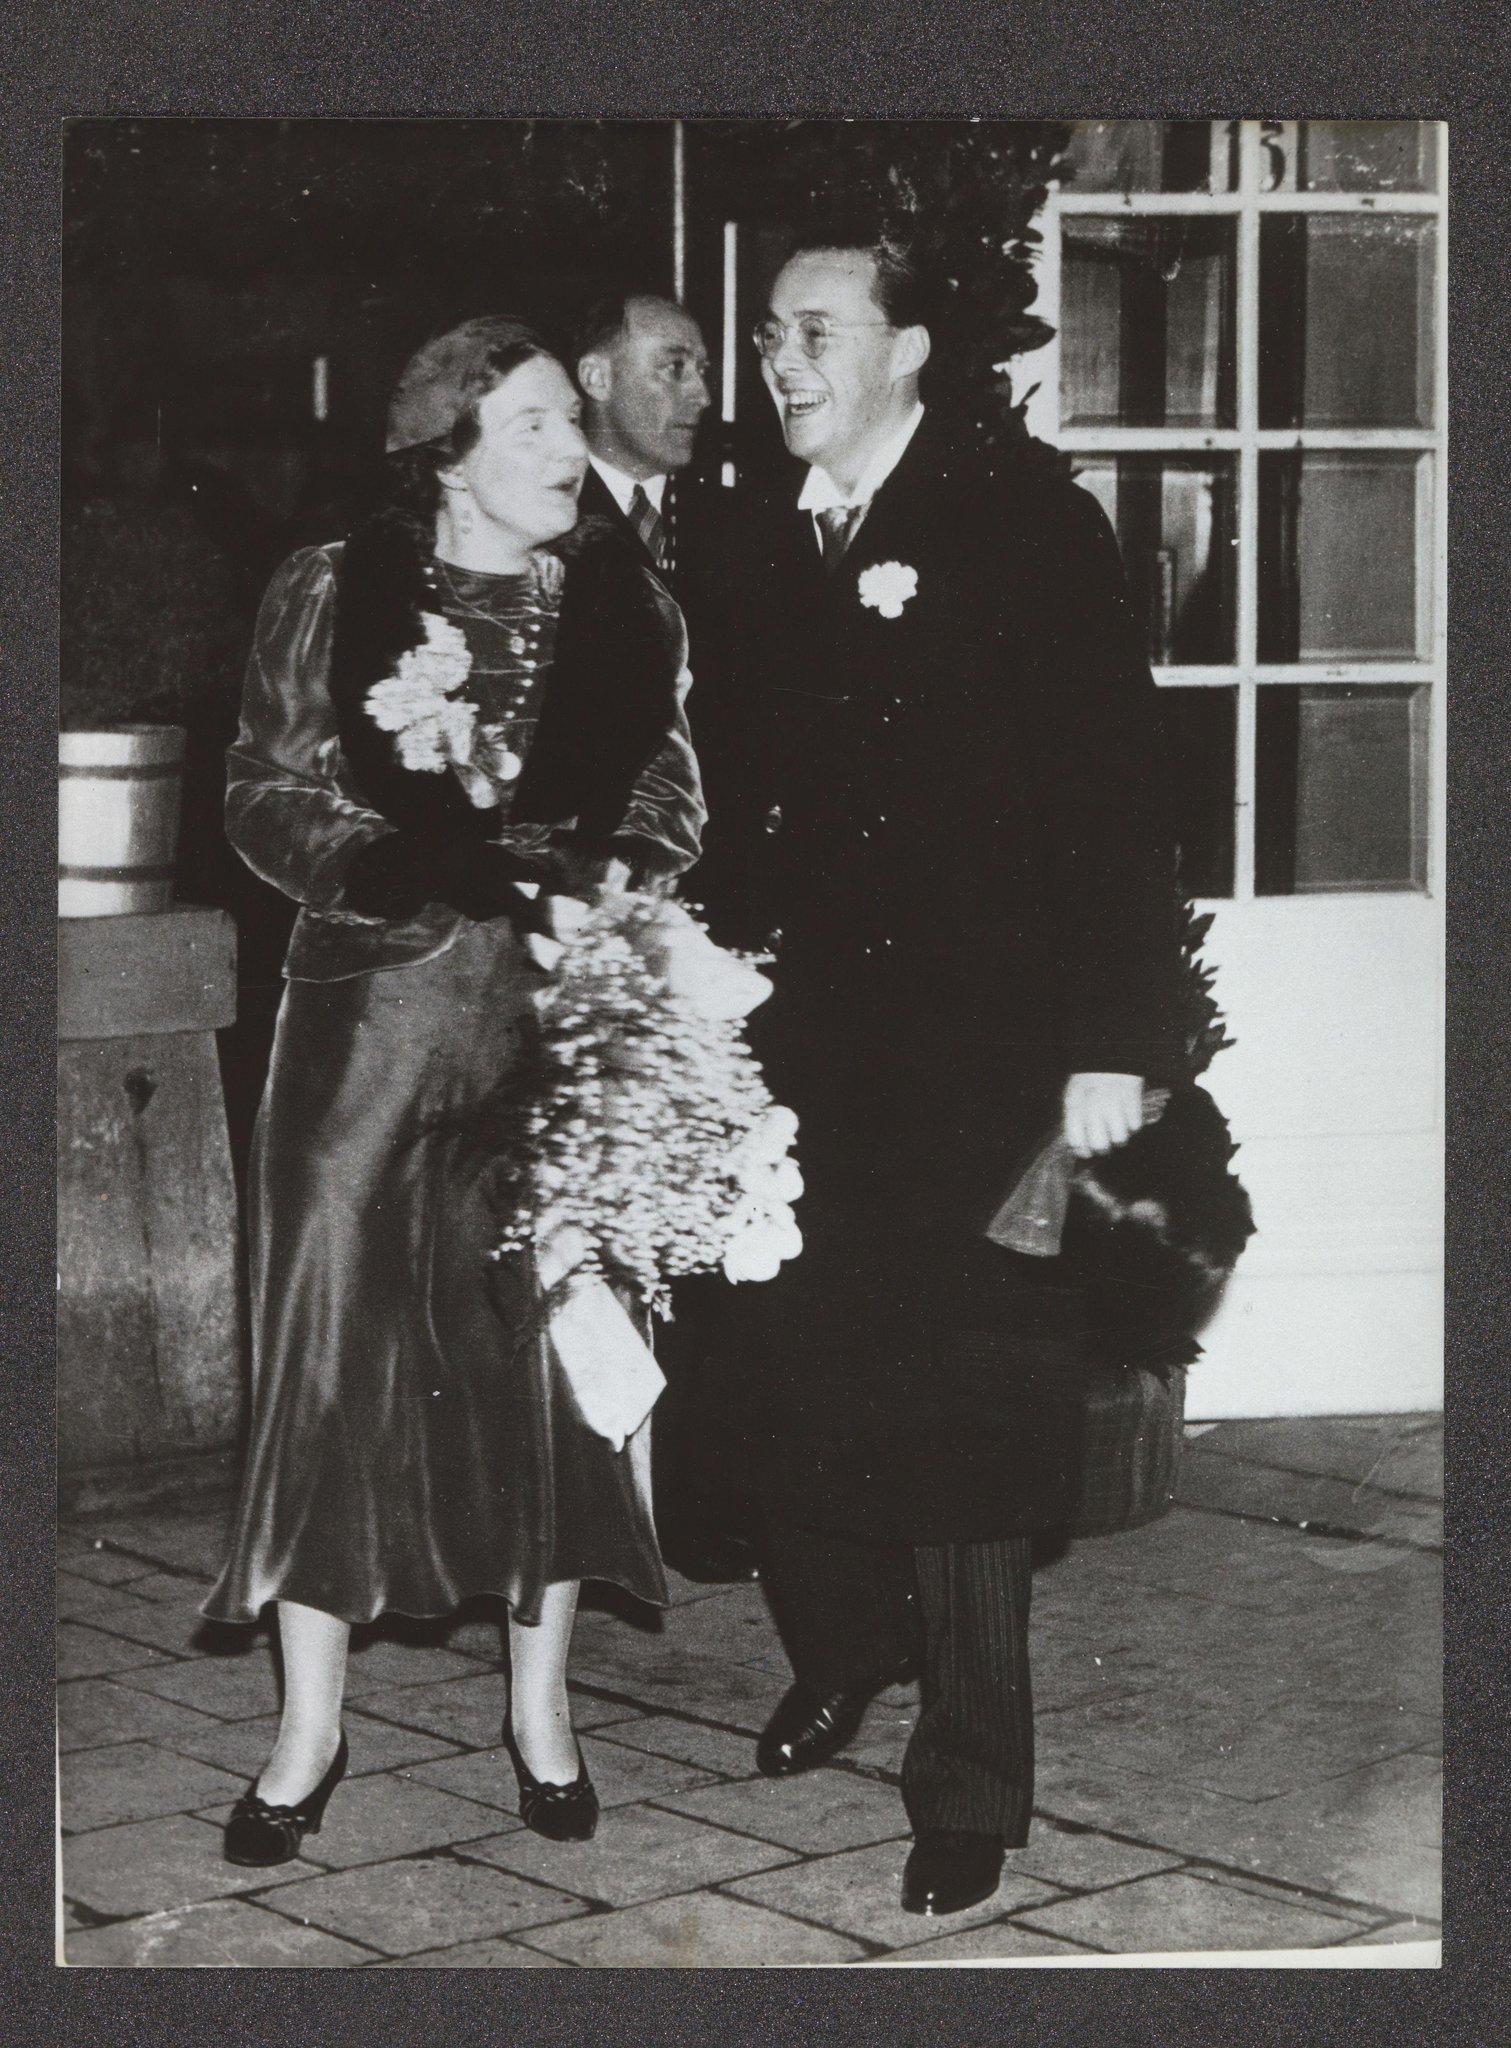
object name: photograph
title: Koningin Juliana en Prins Bernhard in winterkleding bij een officiele gelegenheid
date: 1950-1965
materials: paper, photographic support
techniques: gelatin silver print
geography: netherlands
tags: utrecht, bernhard (prins der nederlanden), the hague, juliana of the netherlands